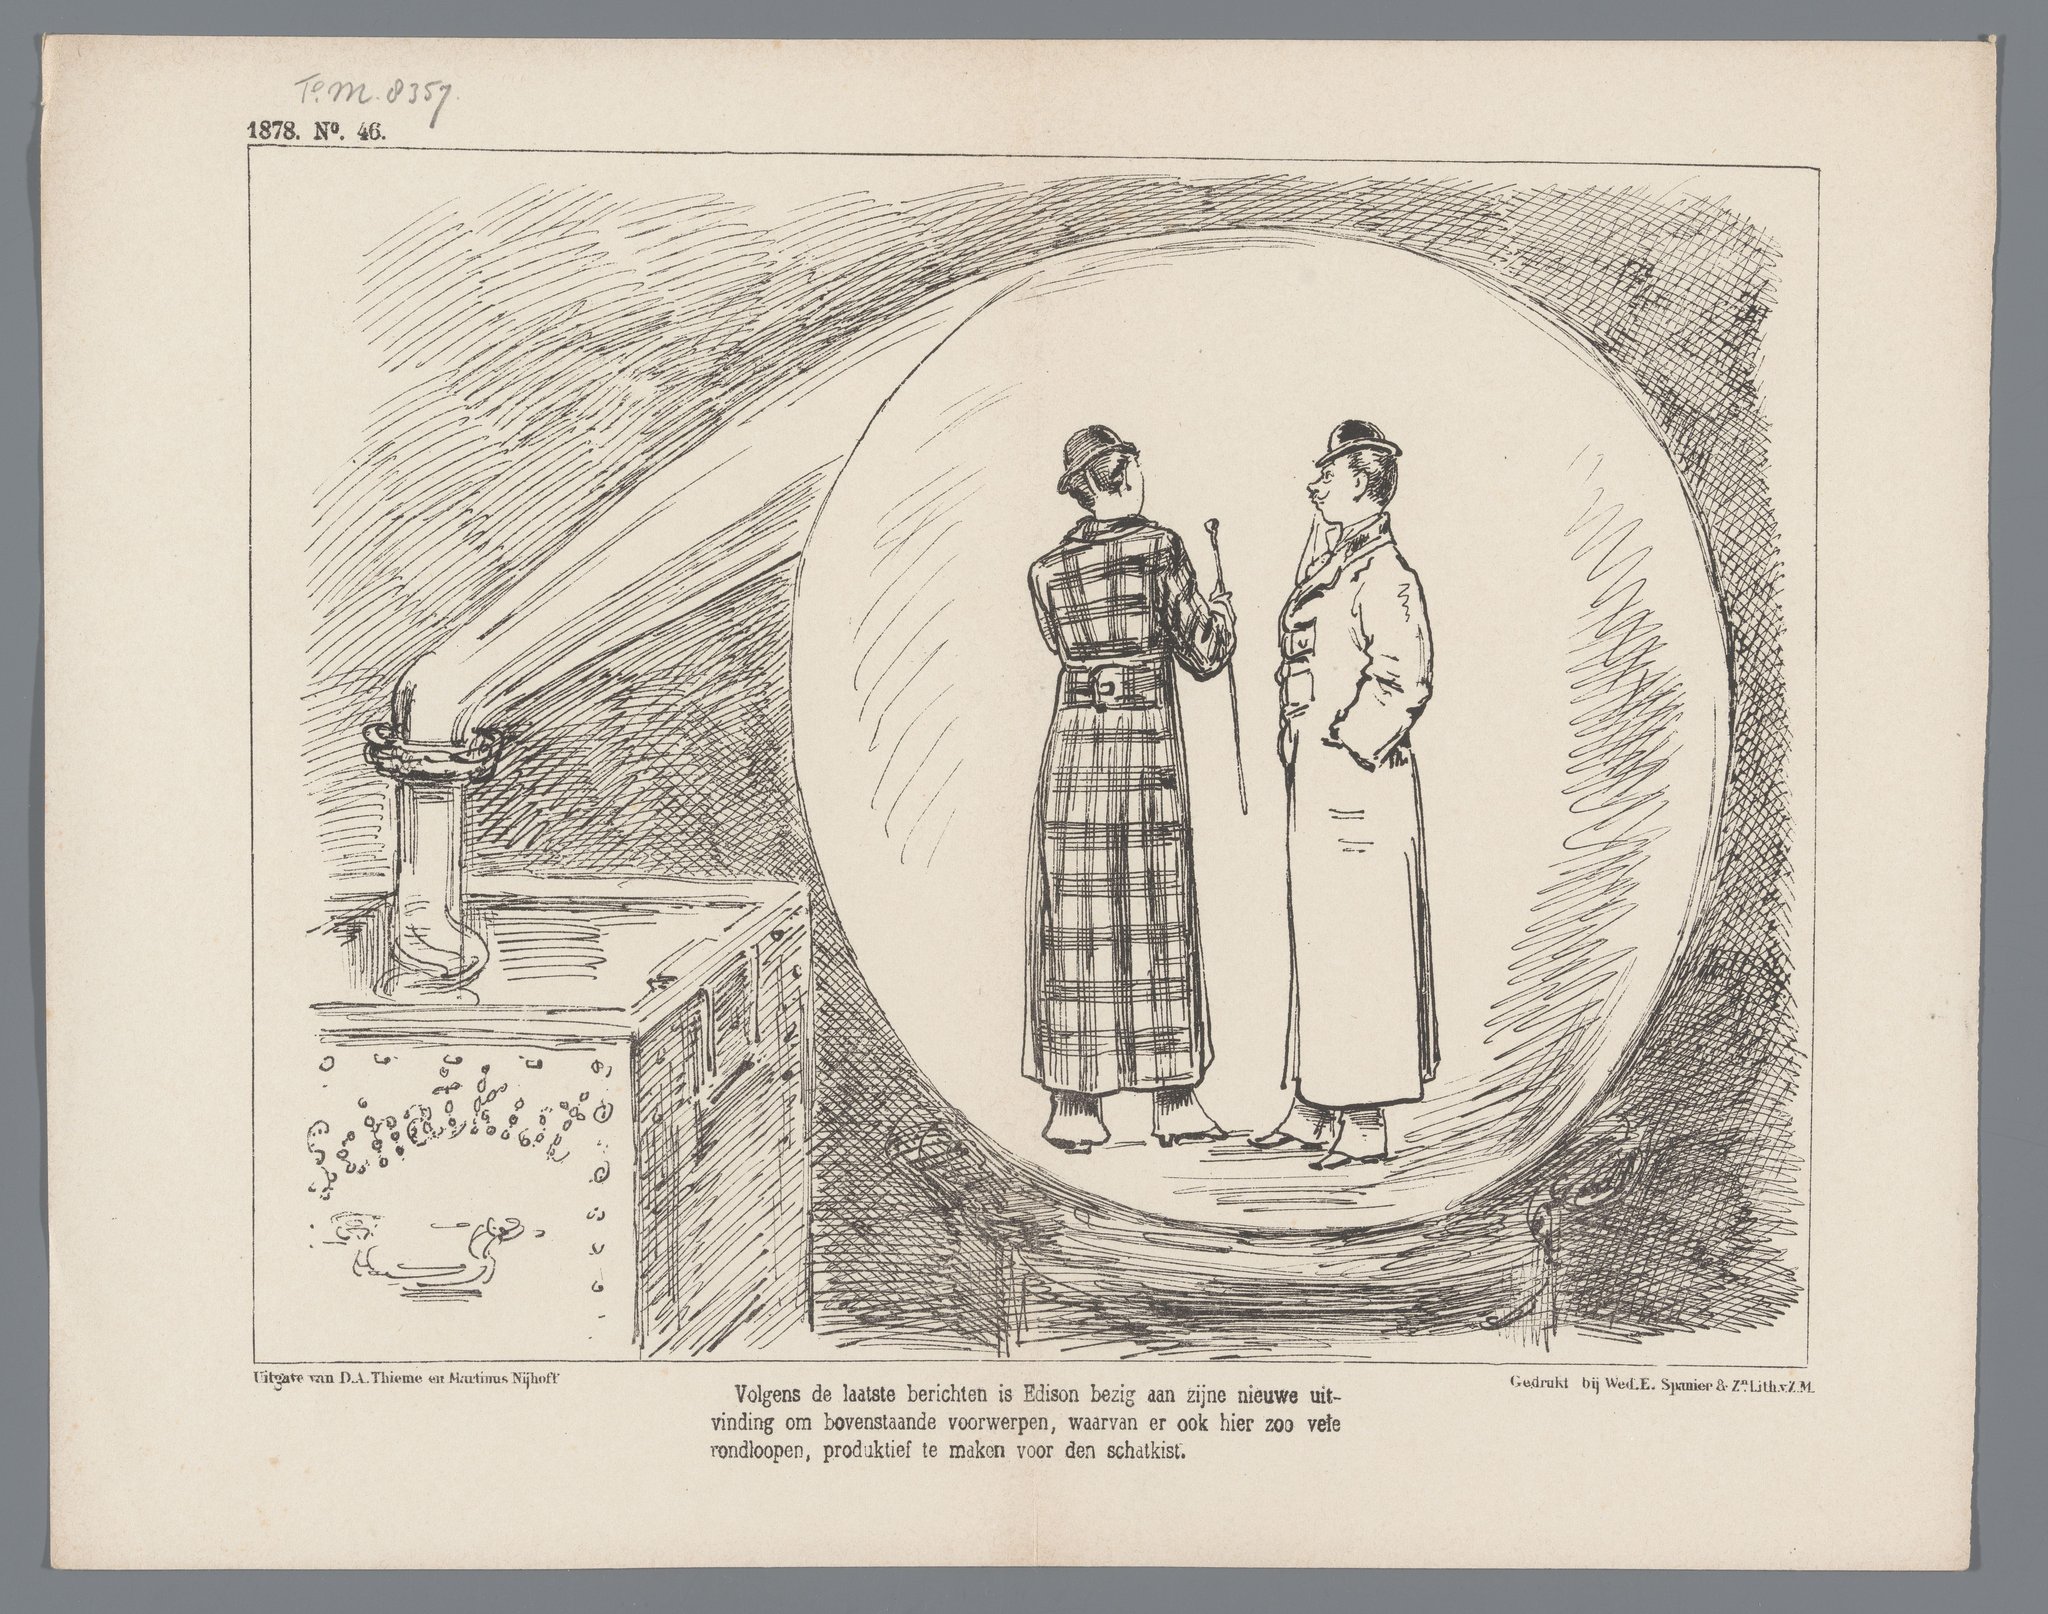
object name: cartoon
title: Spotprent op de Haagse dandies, 1878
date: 1878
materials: paper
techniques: lithograph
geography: netherlands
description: Spotprent met een technische opstelling om de belasting op Haagse dandies terug te laten vloeien in de schatkist. Plaat verschenen bij het weekblad De Nederlandsche Spectator, nr. 46, 1878.